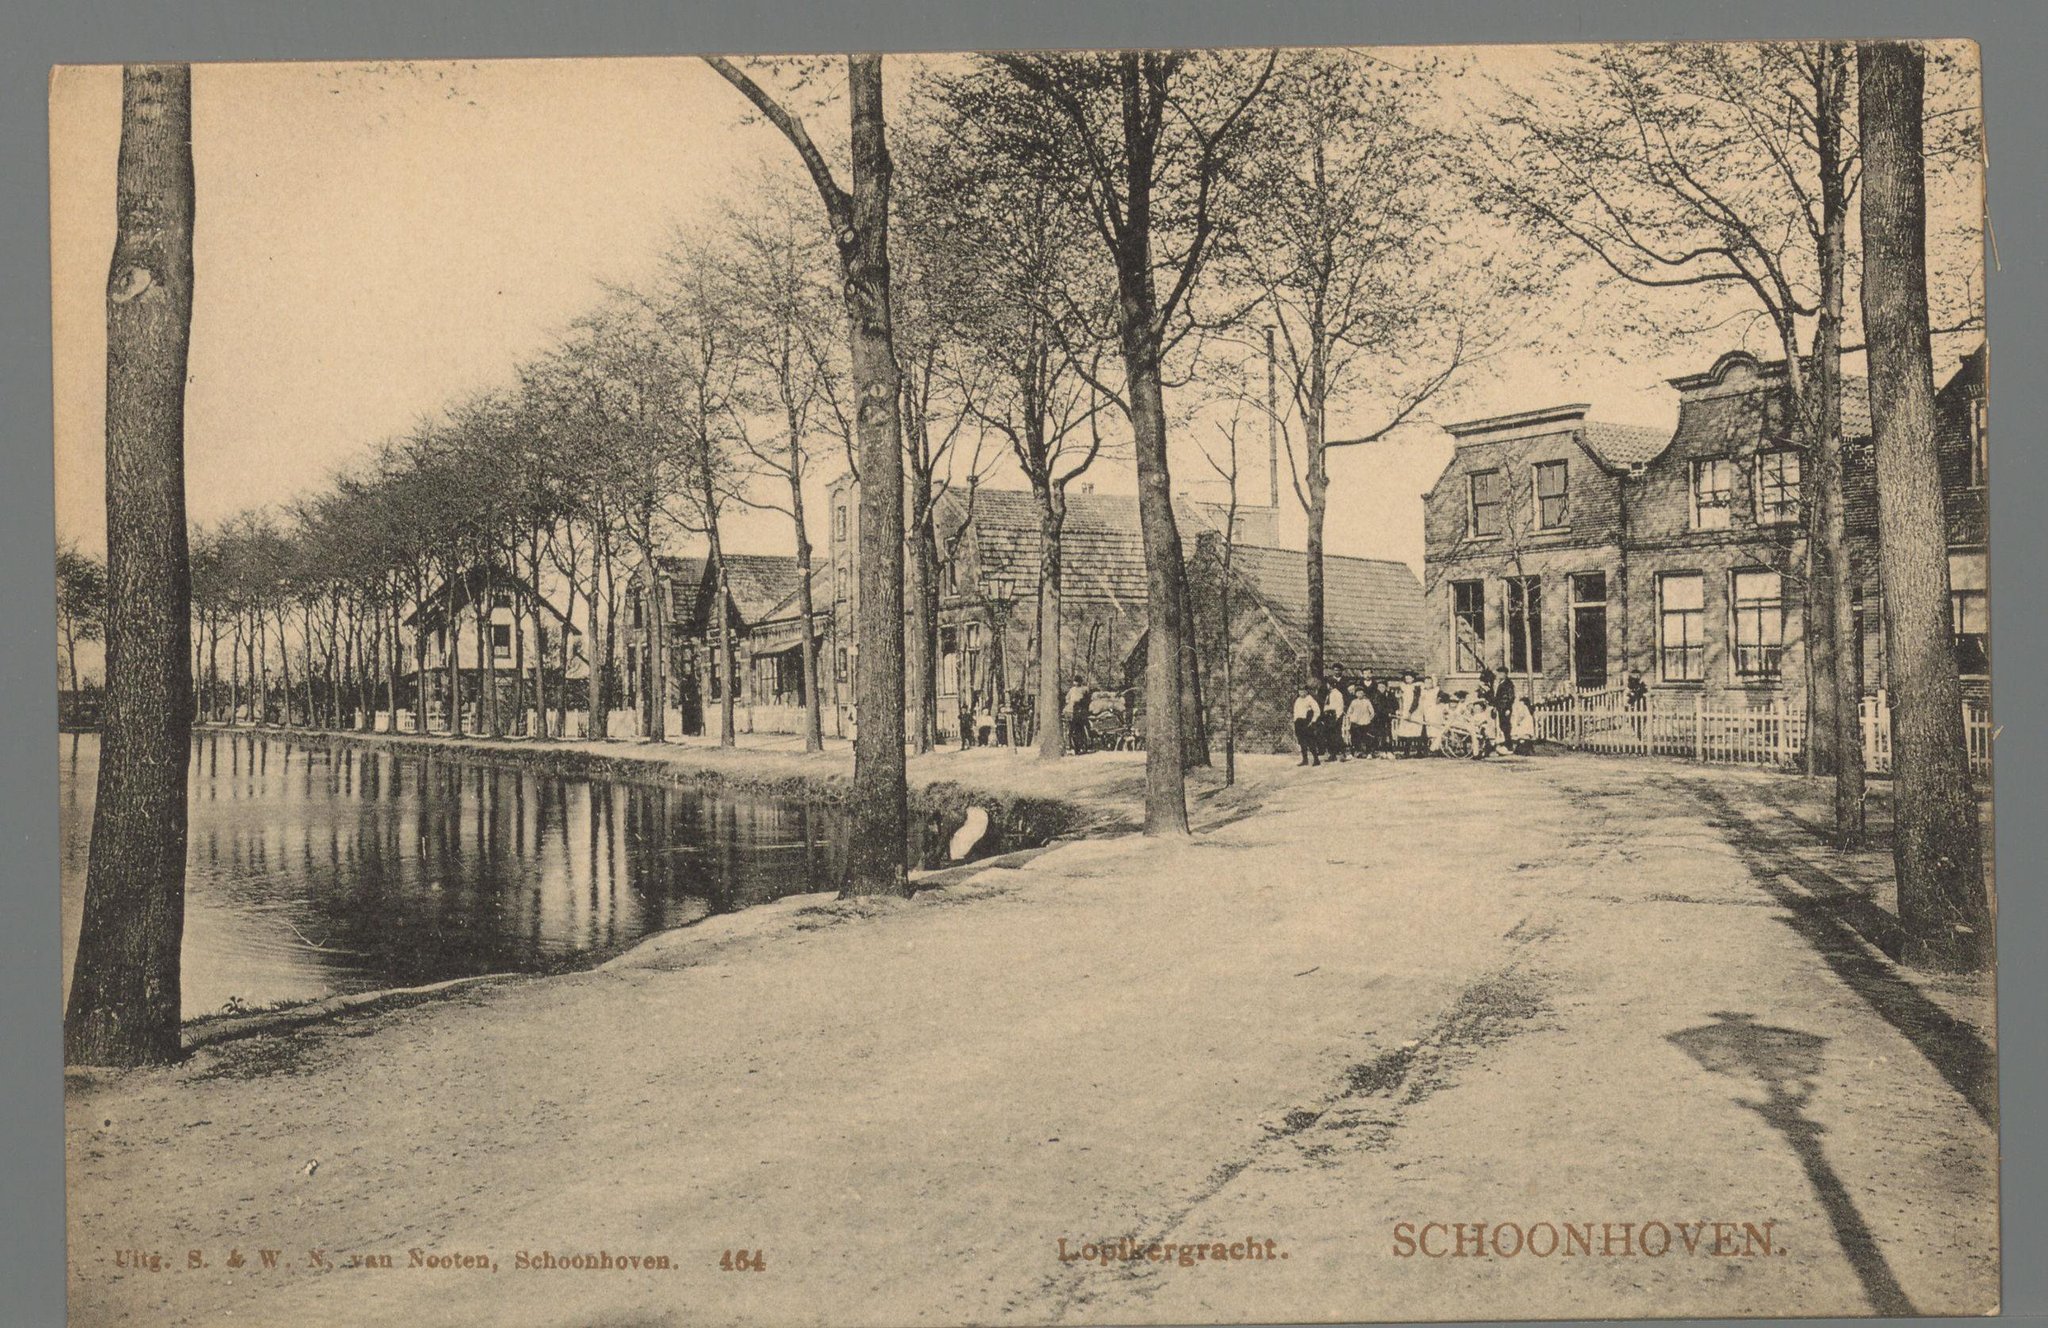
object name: ansichtkaart, prentbriefkaart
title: Lopikergracht. Schoonhoven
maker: Anonymous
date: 1905-1919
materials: cardboard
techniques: photograph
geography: schoonhoven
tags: canals, waters (in city), street